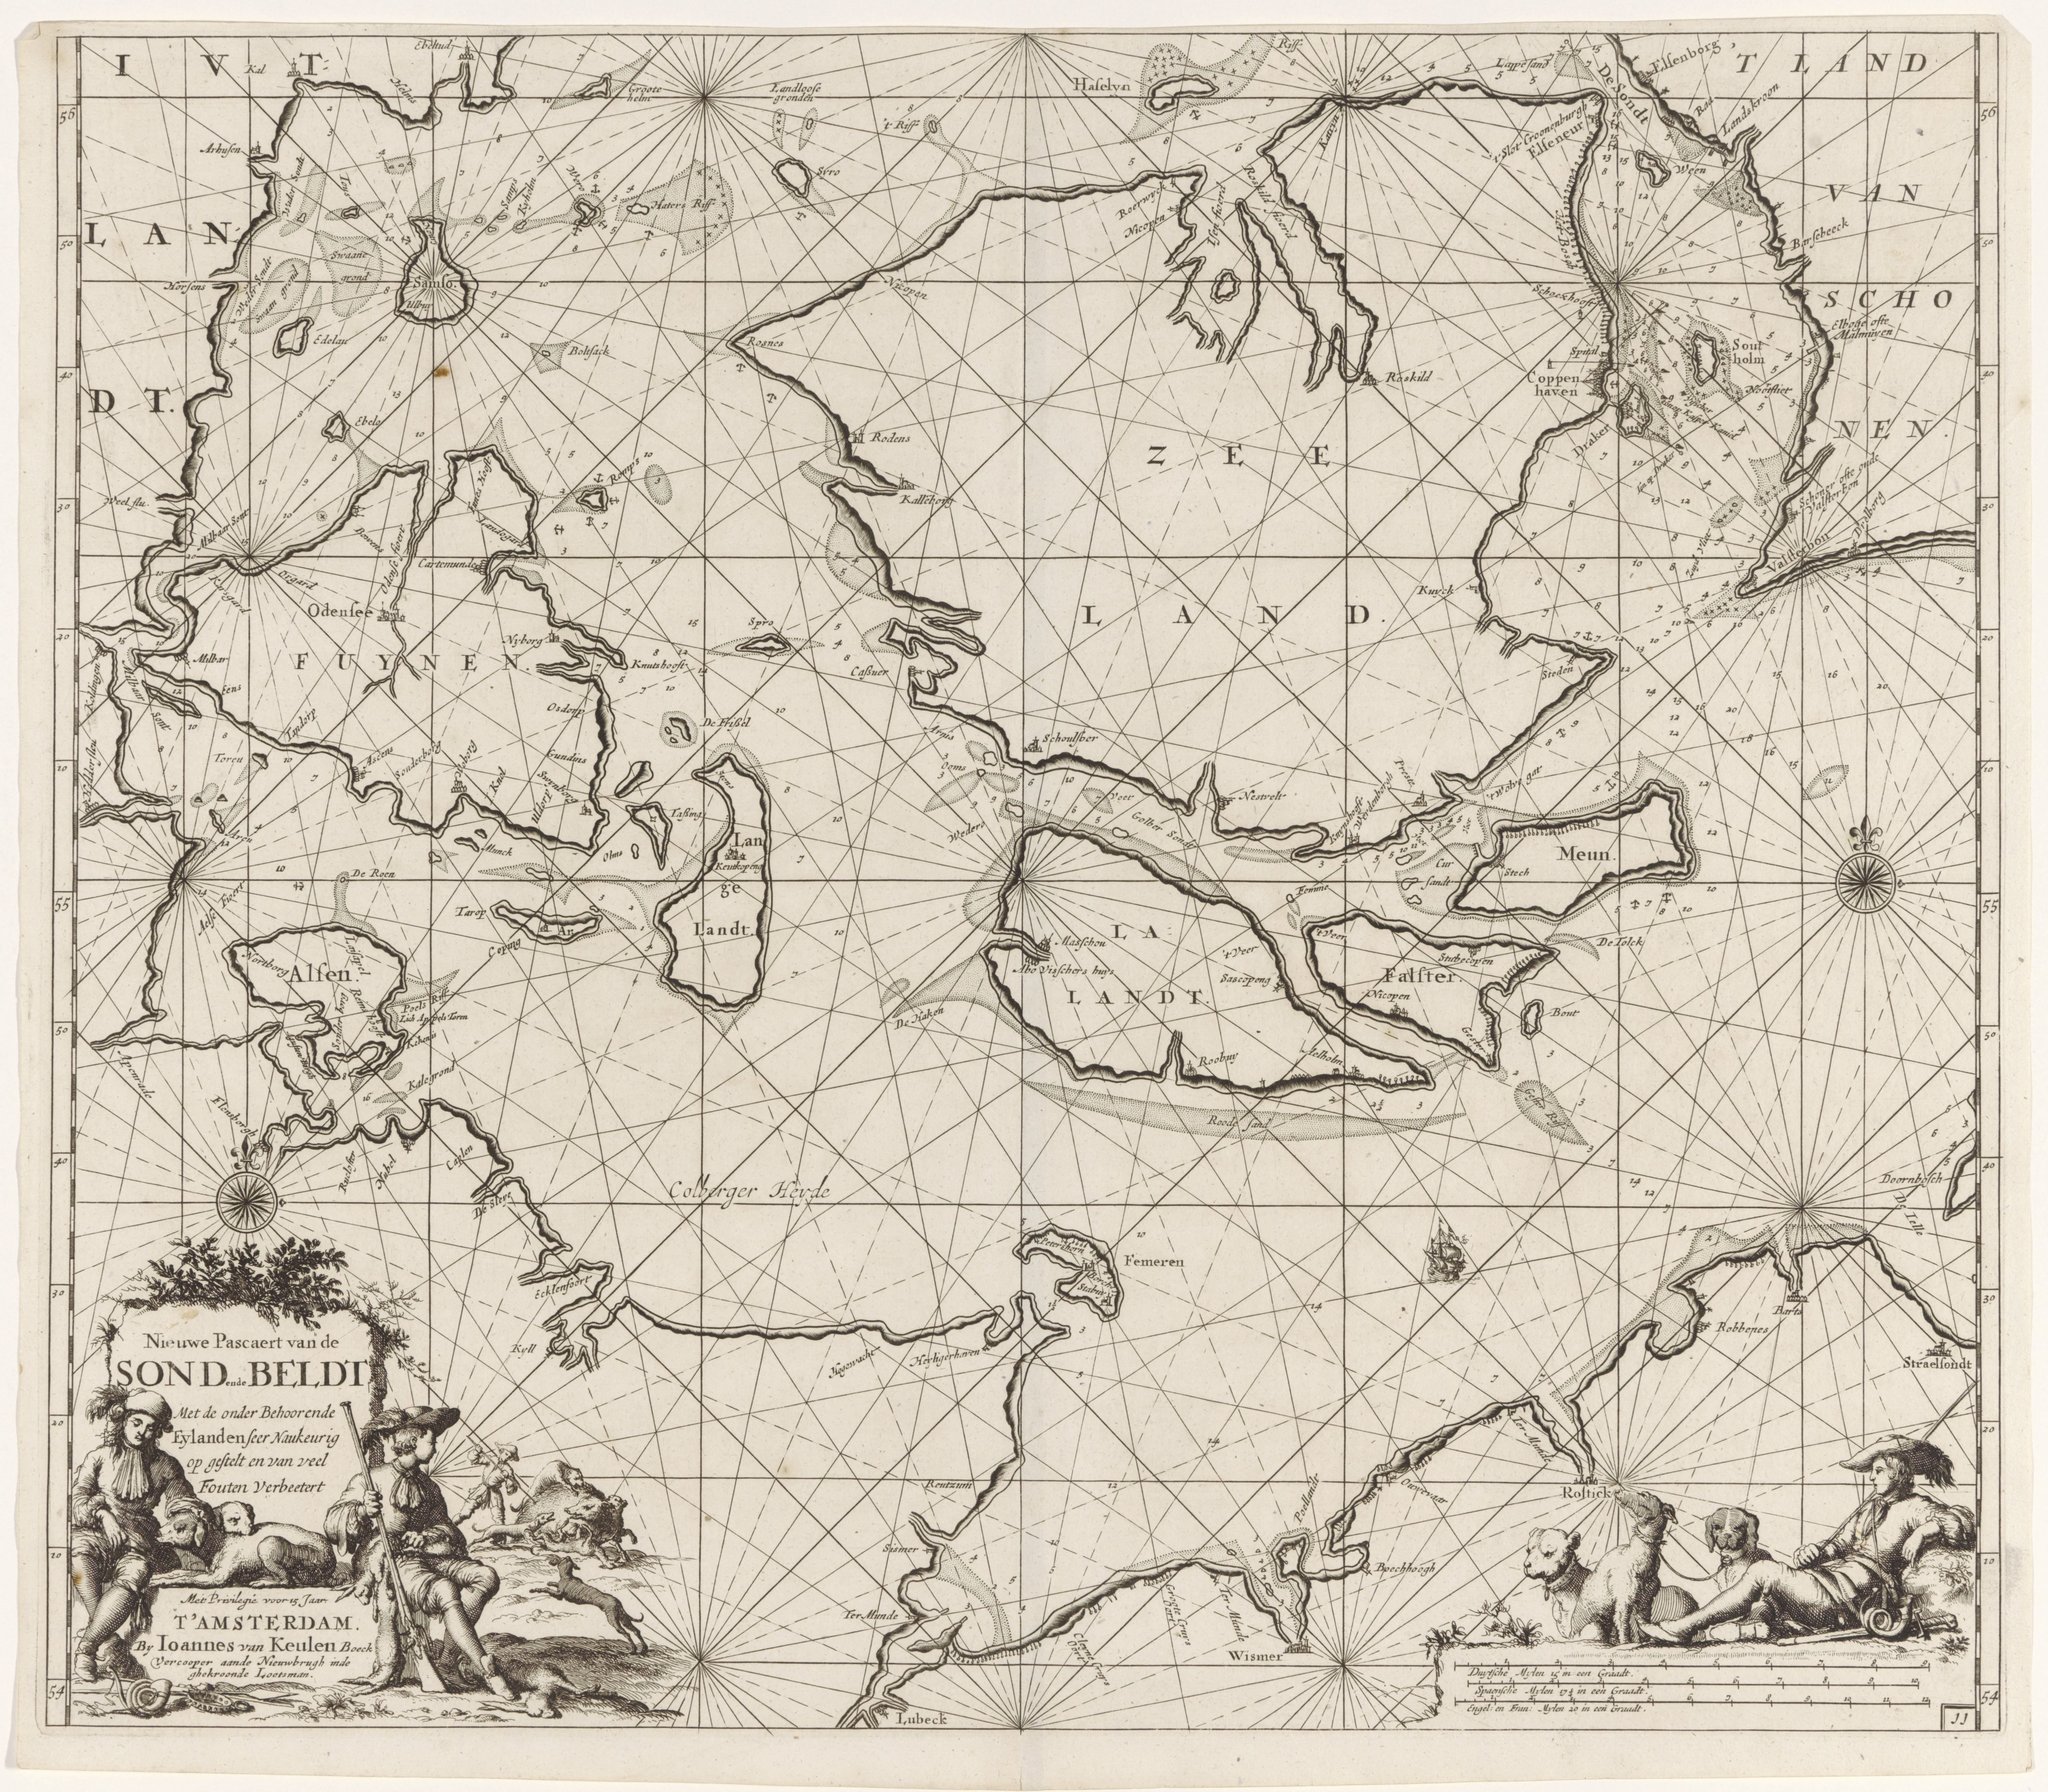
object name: print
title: Paskaart van de Deense Eilanden, met een deel van de kust van Zweden en Duitsland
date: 1681-1799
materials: paper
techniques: engraving, etching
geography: amsterdam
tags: sailing-ship, sailing-boat, hunting dogs, boar-hunting, hunter, germany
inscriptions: collector's mark: Lugt 2228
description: Paskaart van de Deense Eilanden, met een gedeelte van de kust van Zweden en Duitsland, met twee kompasrozen, het Noorden ligt boven. Linksonder een cartouche met de titel en het adres van de uitgever, waarbij twee jagers zitten. Een van de jagers kijkt hoe zijn kameraad samen met enkele honden op een wild zwijn jaagt. Rechtsonder ligt een vierde jager met zijn drie honden op de schaalverdeling, weergegeven in Duitse, Spaanse en Engelse of Franse mijlen.